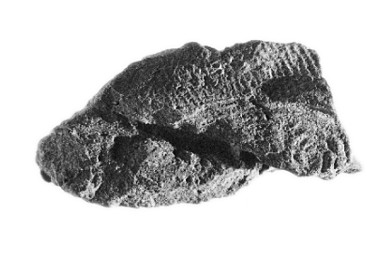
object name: sealing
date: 1981-1640 BCE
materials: mud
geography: egypt